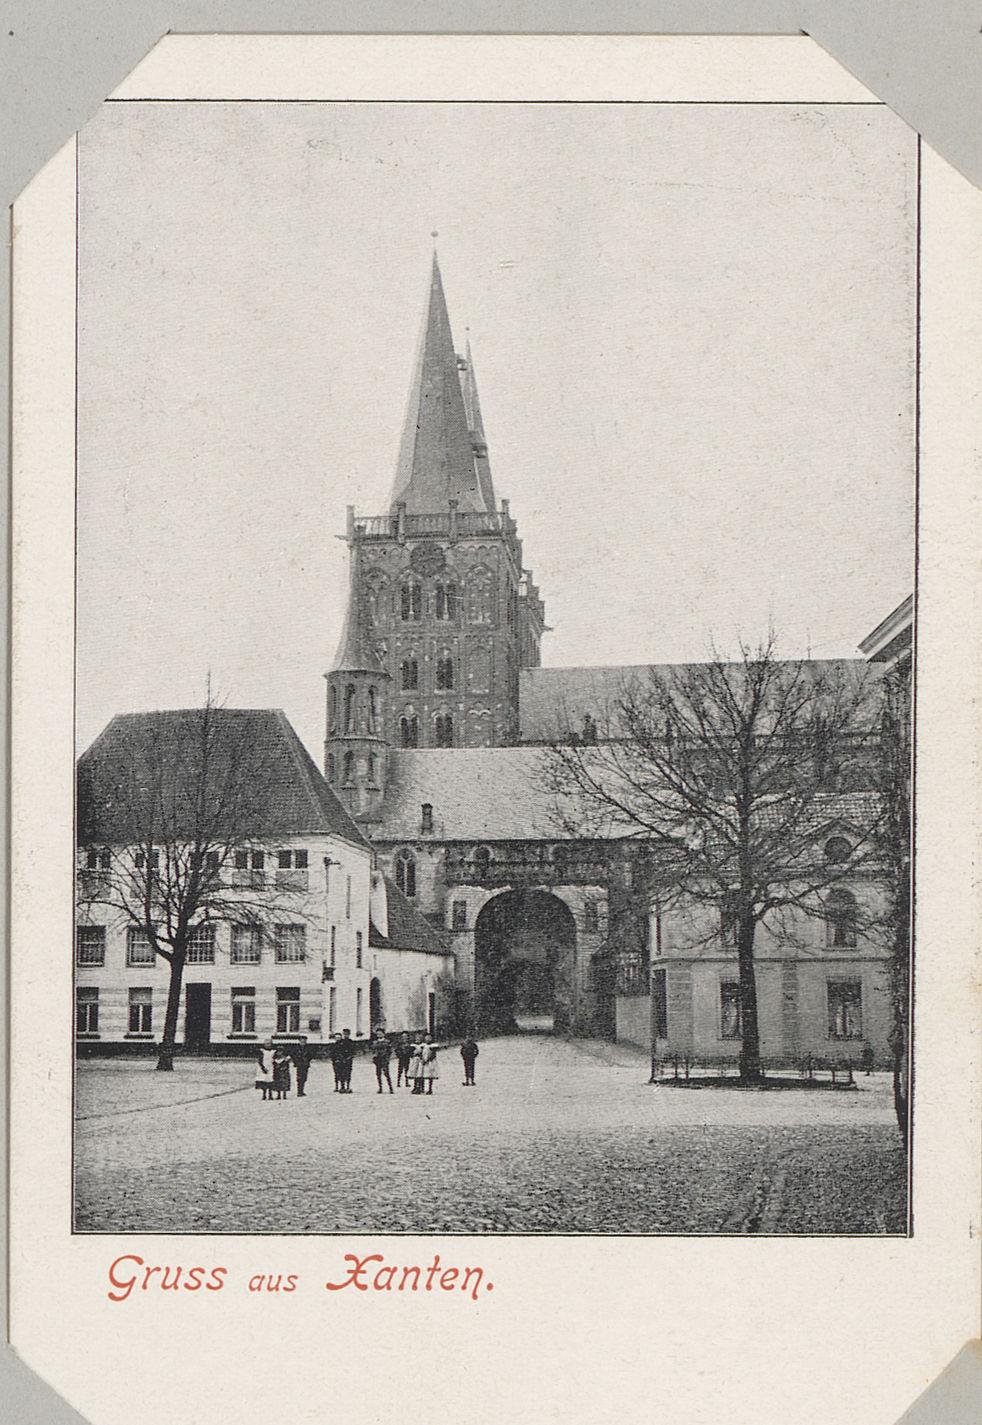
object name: ansichtkaart, prentbriefkaart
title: Gezicht op de Michaelstor en de dom te Xanten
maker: Anonymous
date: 1890-1902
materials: cardboard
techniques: autotype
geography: xanten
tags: church (exterior), market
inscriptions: inscription: ‘Gruss aus Xanten./ Druck u. Verlag v. Bergr. Krams, Xanten.’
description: Deze prent maakt deel uit van een album.